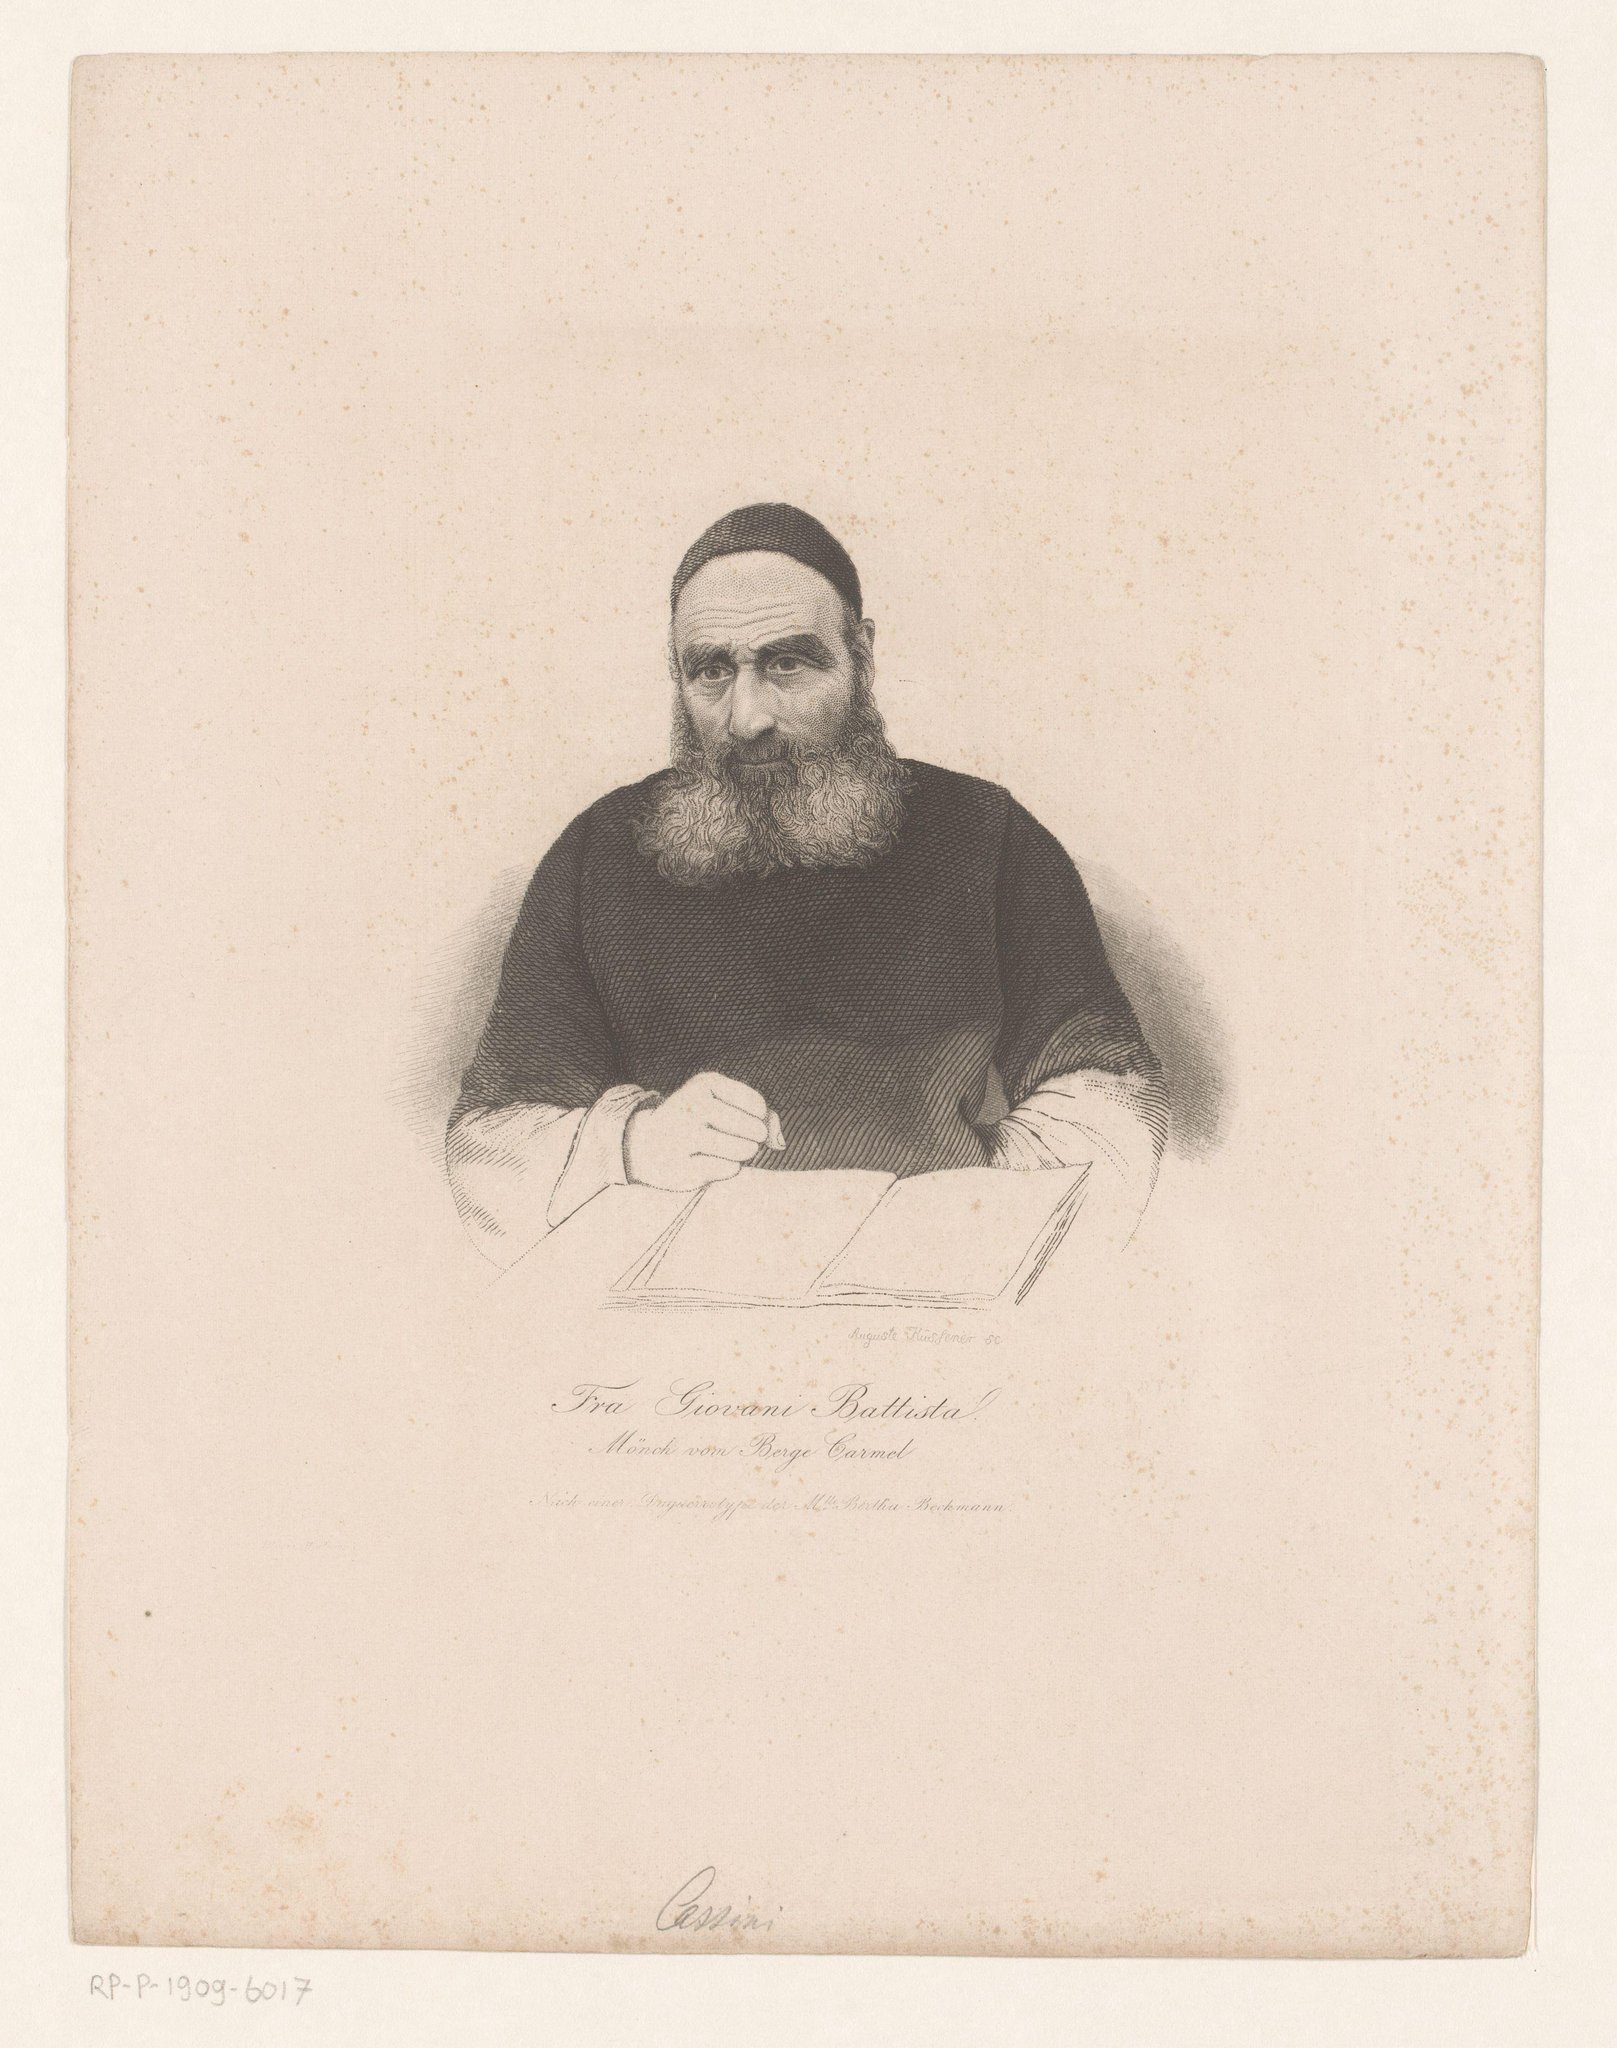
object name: print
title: Portret van de monnik Giovani Battista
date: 1839-1877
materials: paper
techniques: etching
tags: historical persons, monk(s), friar(s)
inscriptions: collector's mark: Lugt 2228